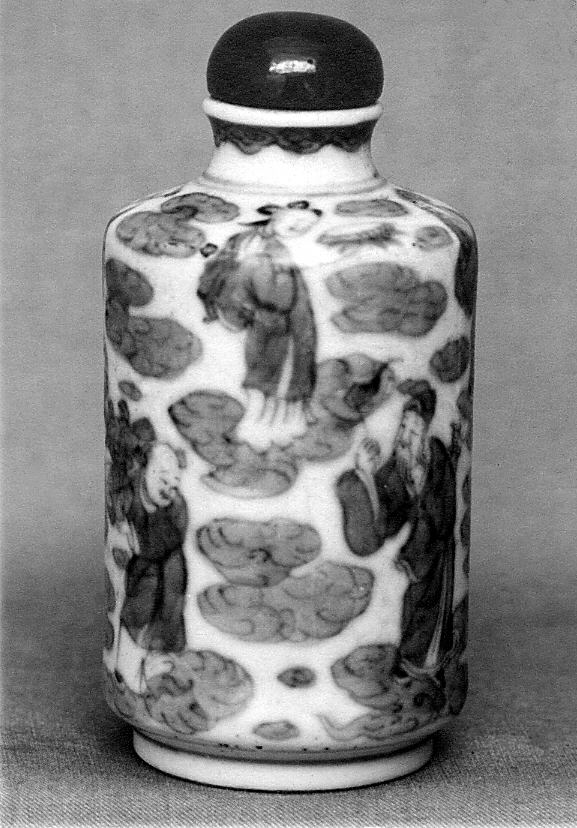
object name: snuff bottle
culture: chinese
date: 1662-1722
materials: porcelain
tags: human figures